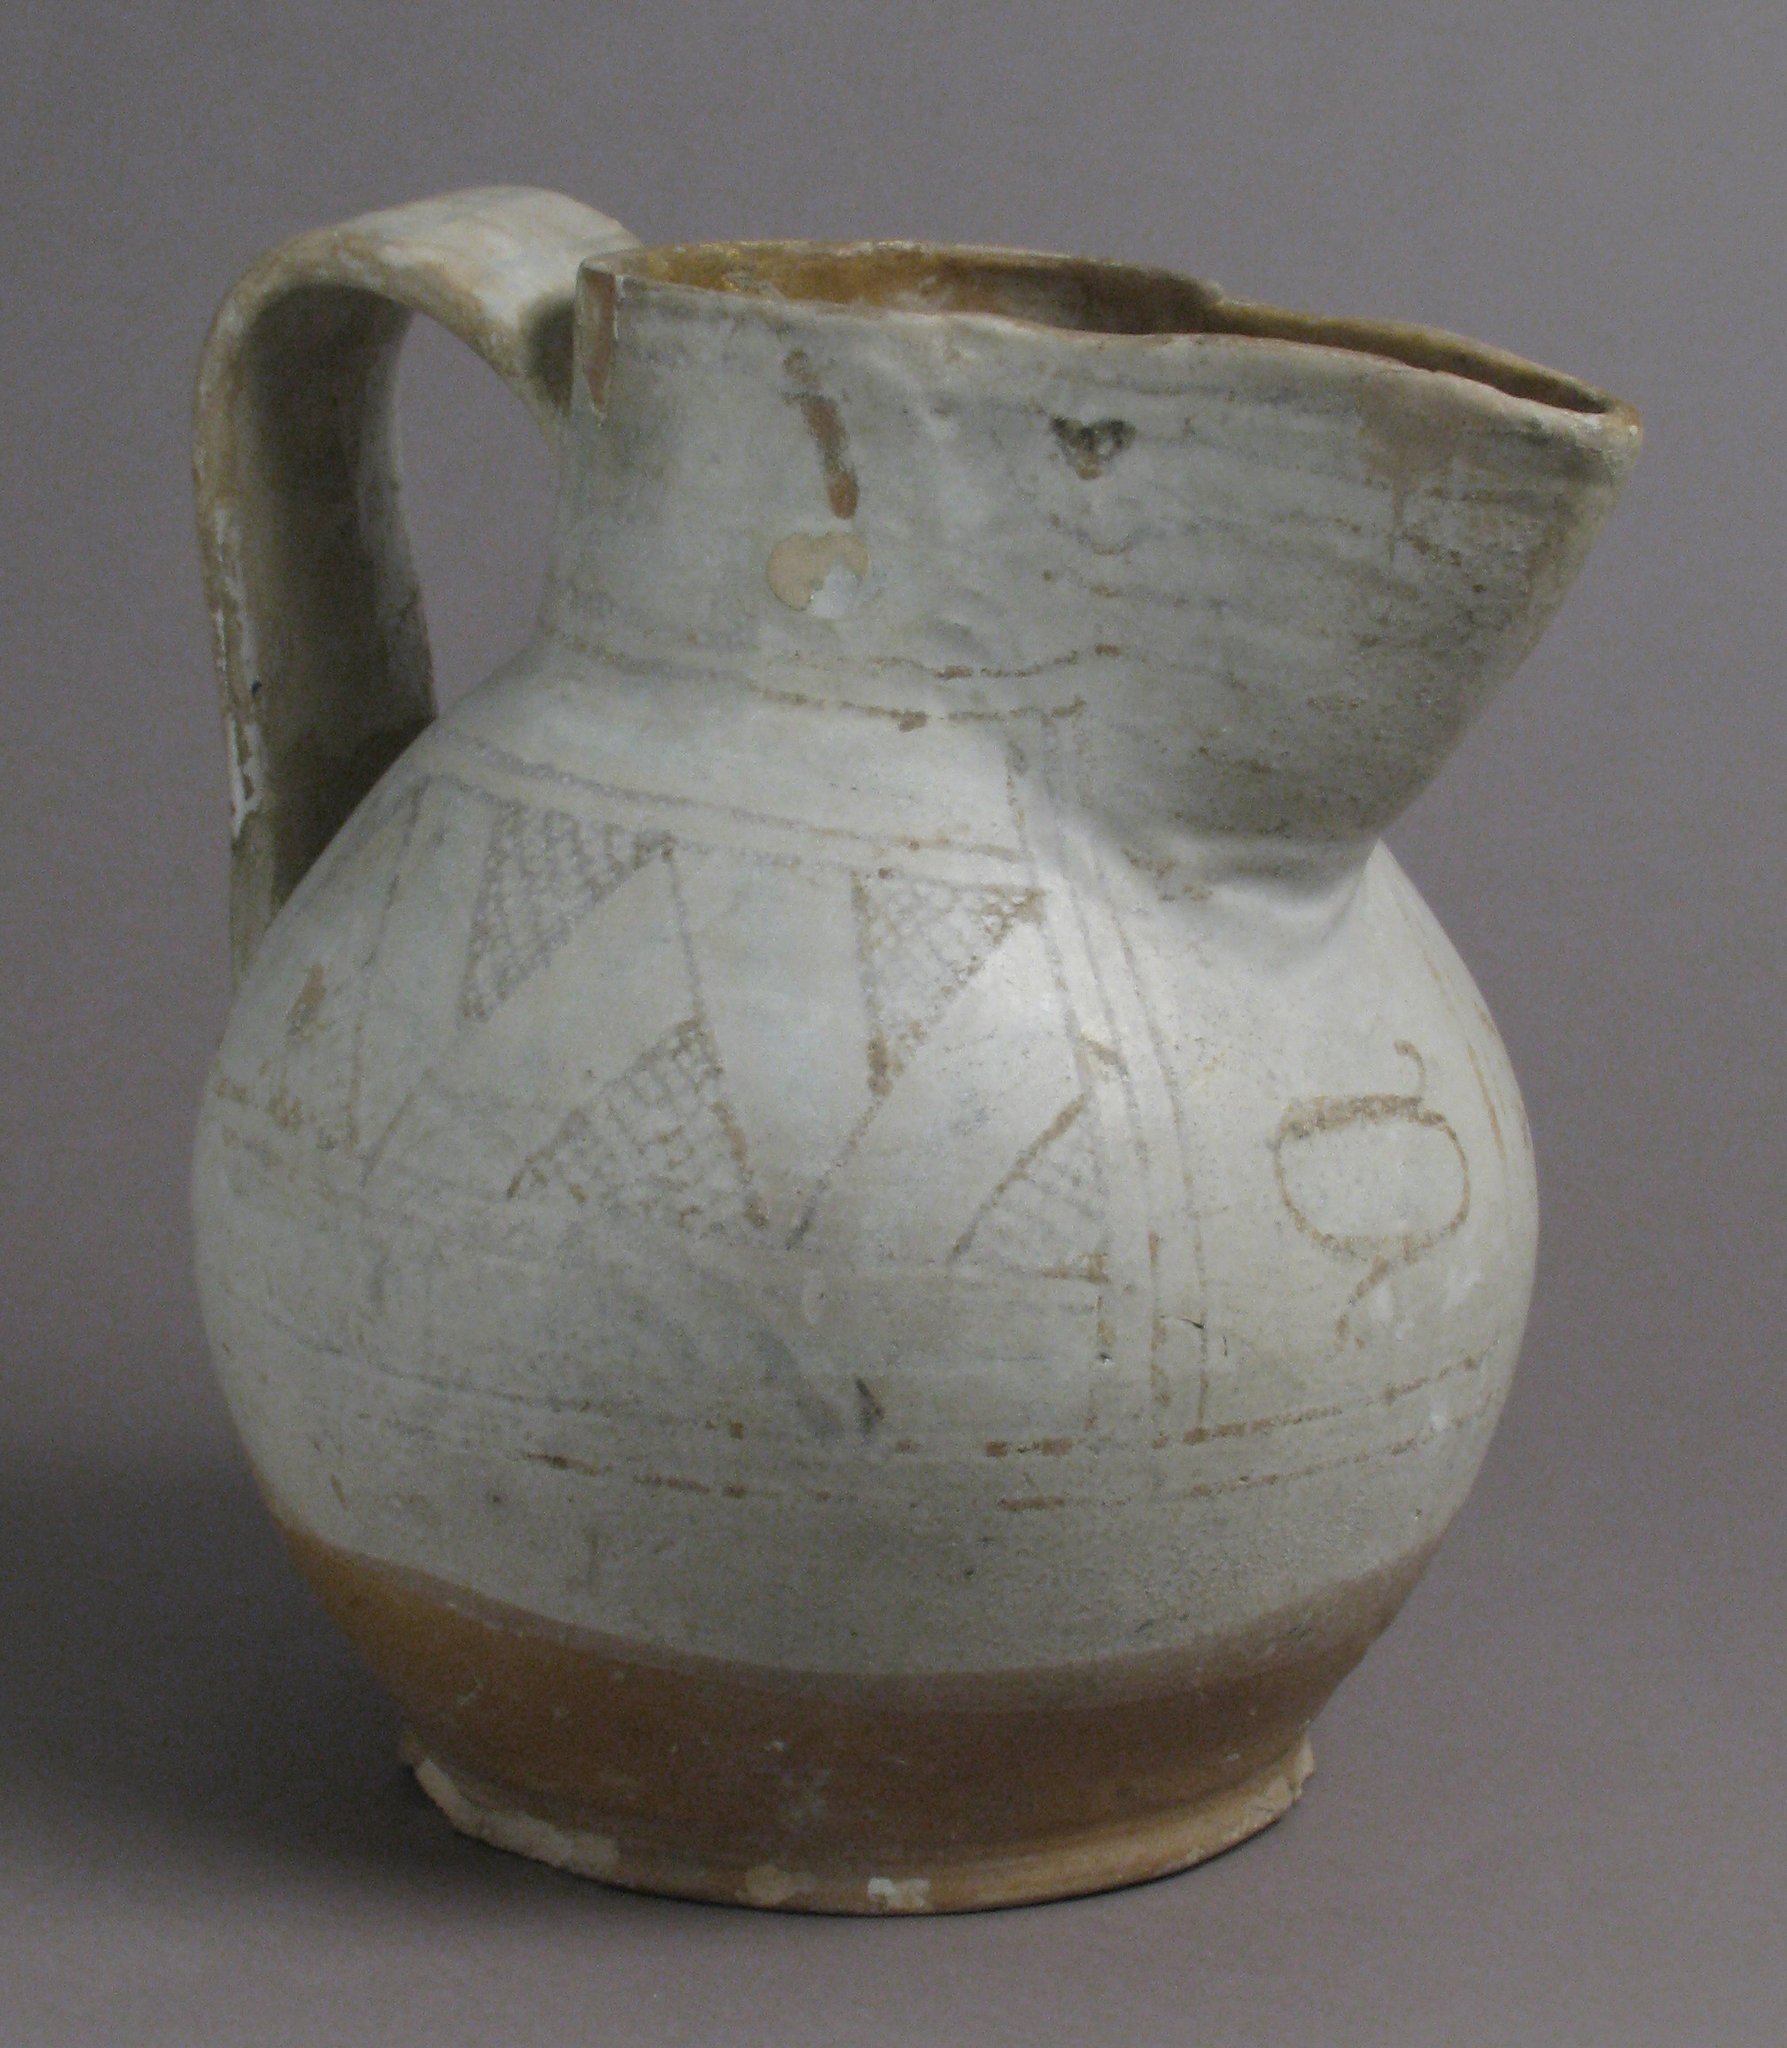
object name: jug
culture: italian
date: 1400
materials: earthenware, glaze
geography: italy